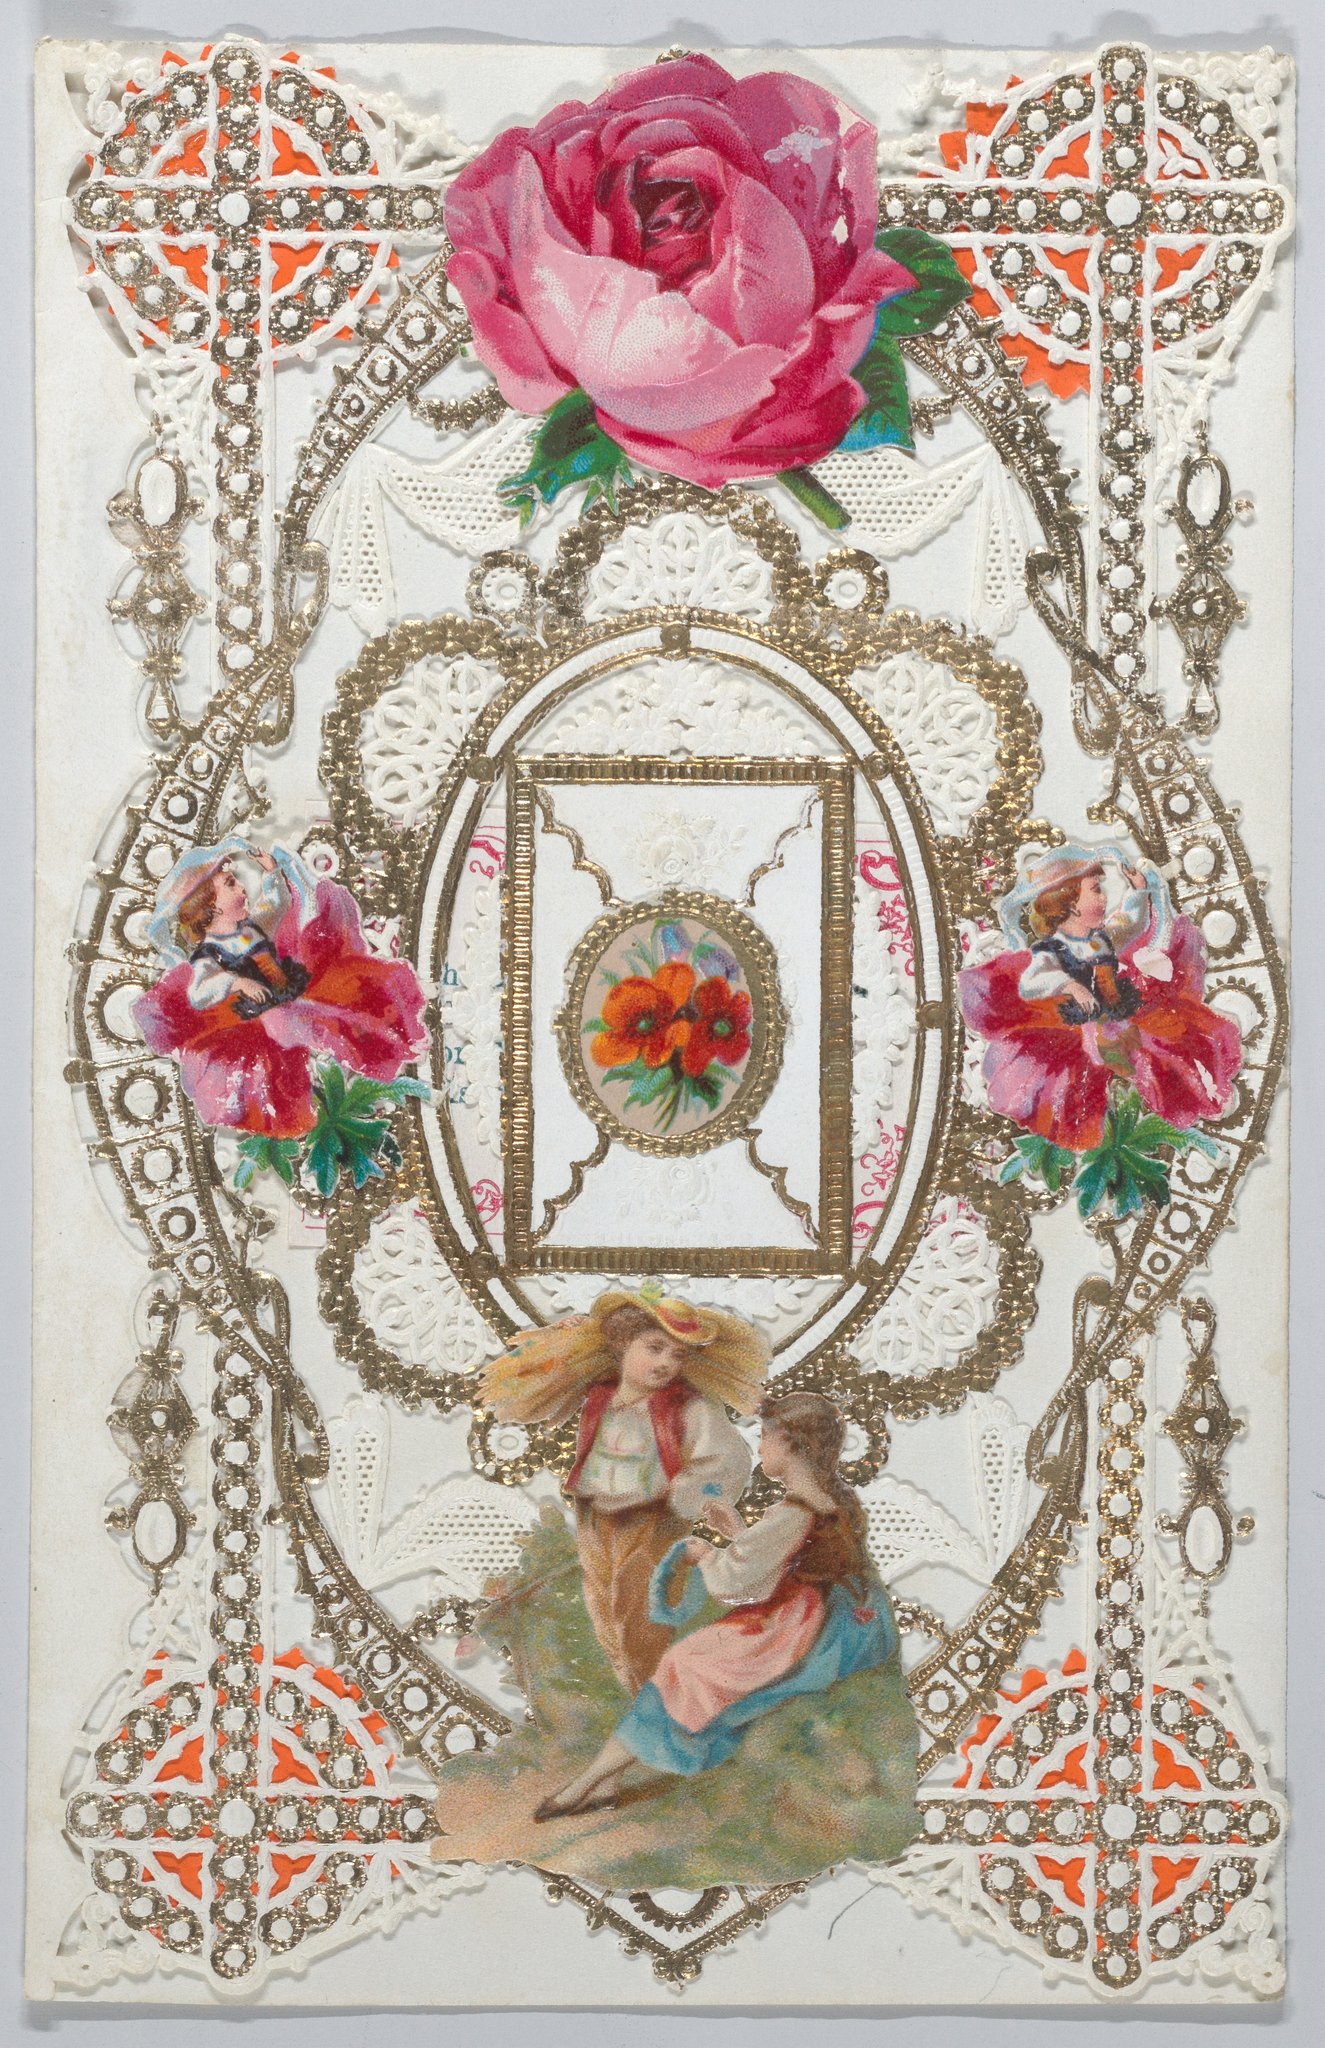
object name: valentine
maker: esther howland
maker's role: artist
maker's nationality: american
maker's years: 1828-1904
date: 1834-1866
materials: lace, paper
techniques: cutting